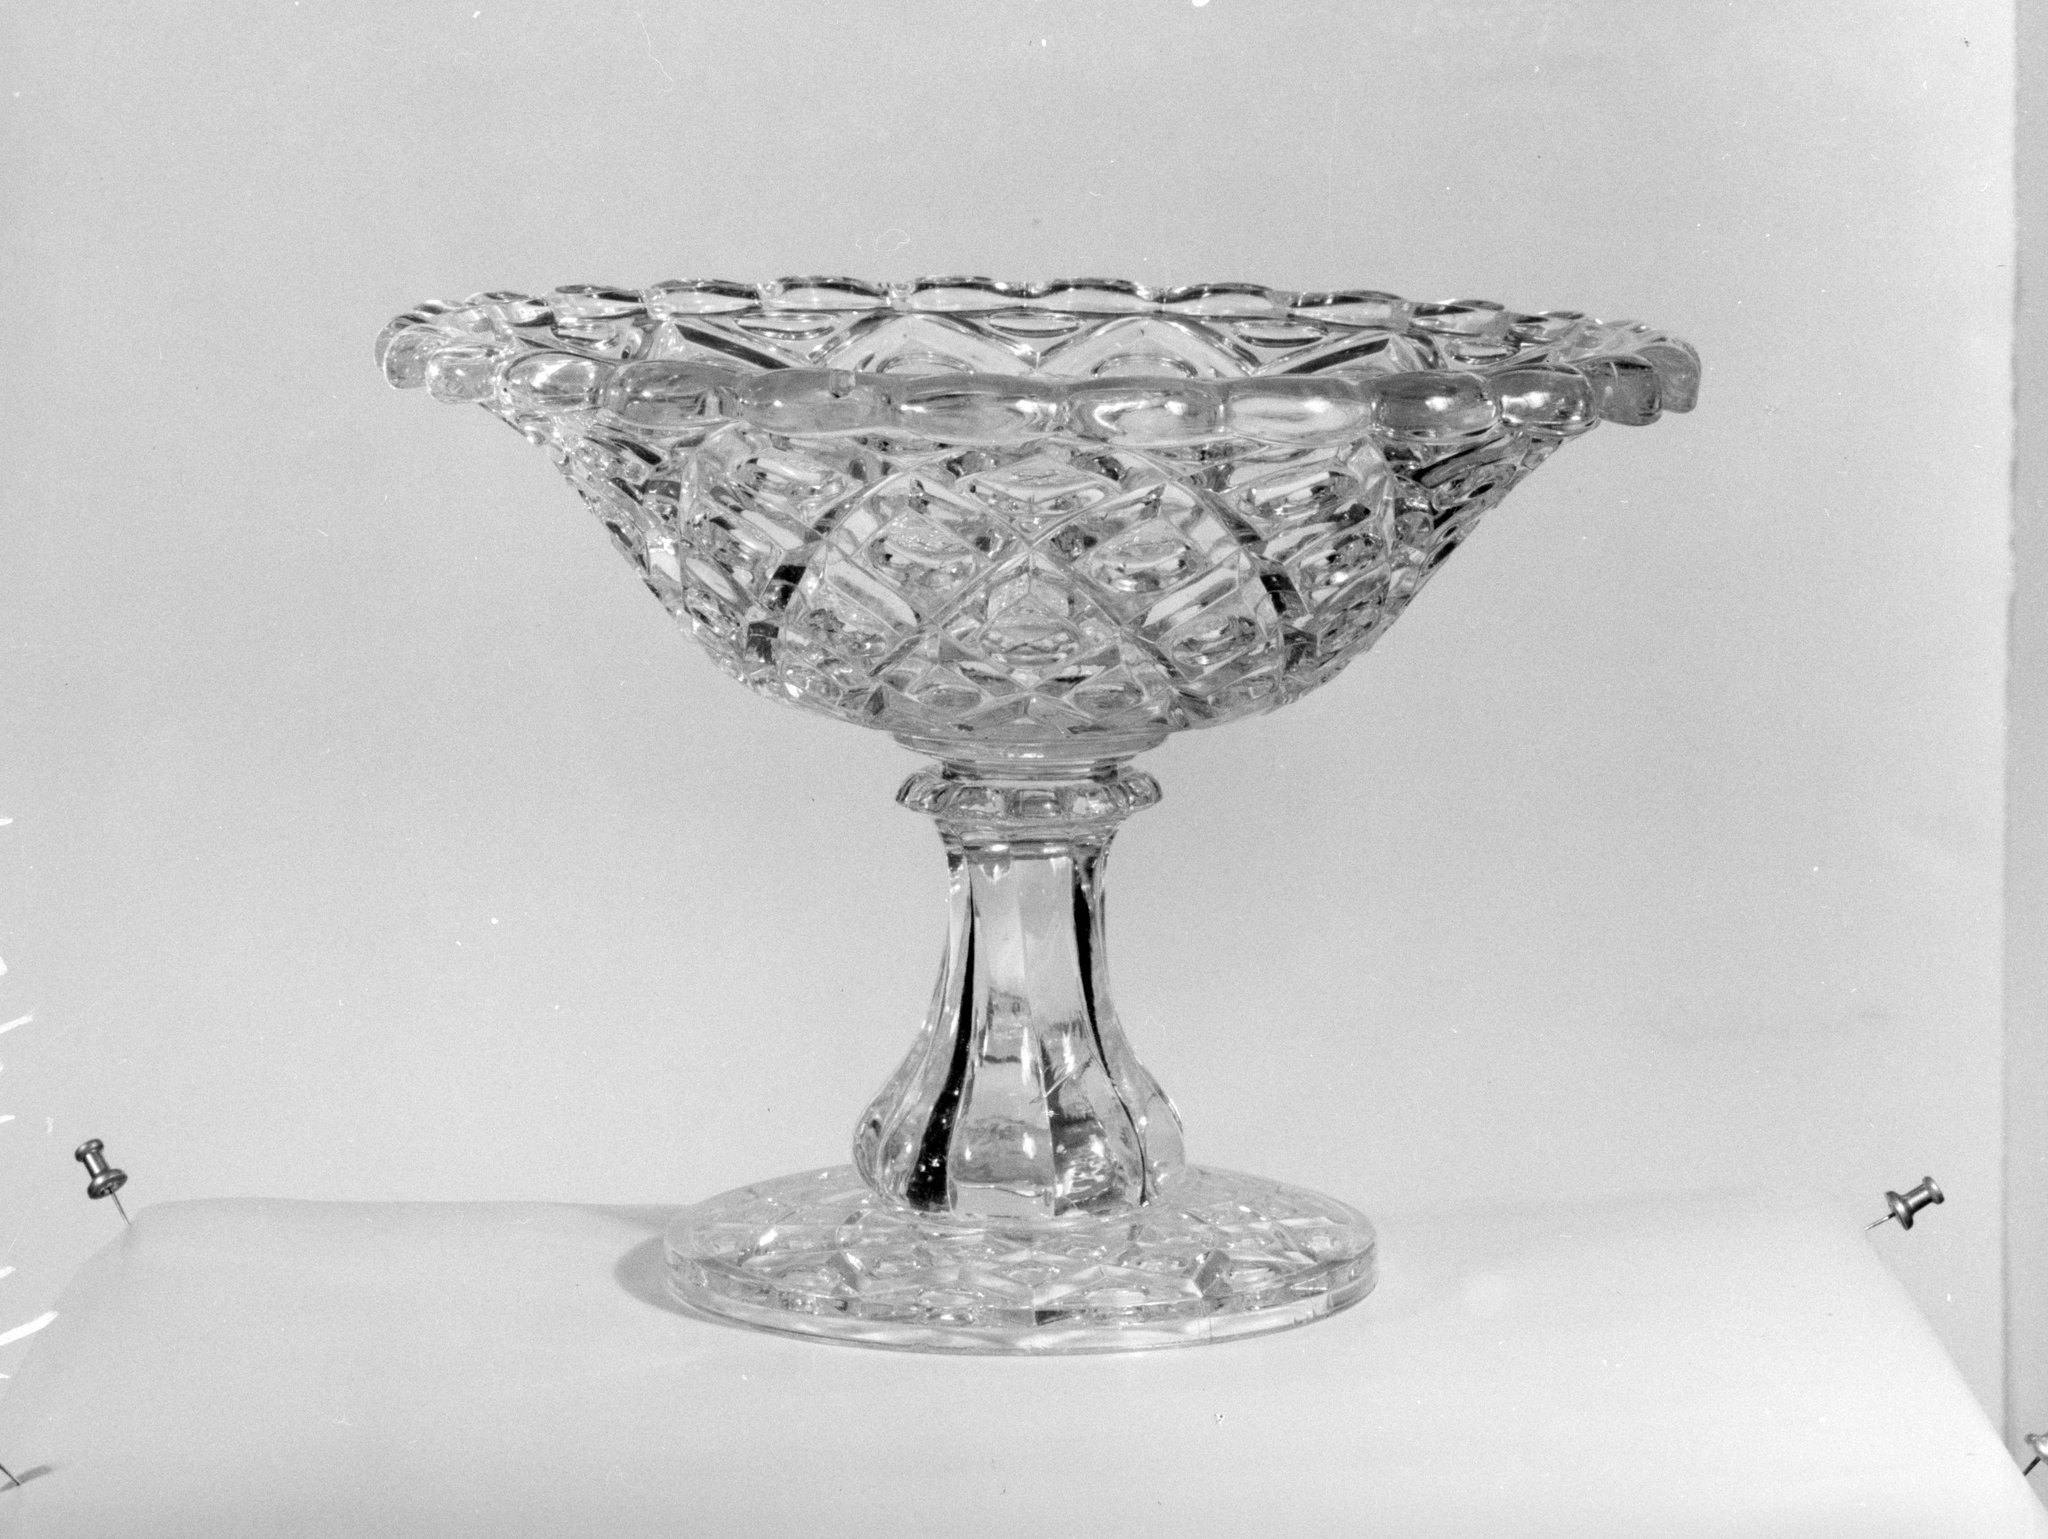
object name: compote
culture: american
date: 1850-1860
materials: glass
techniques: pressed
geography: united states